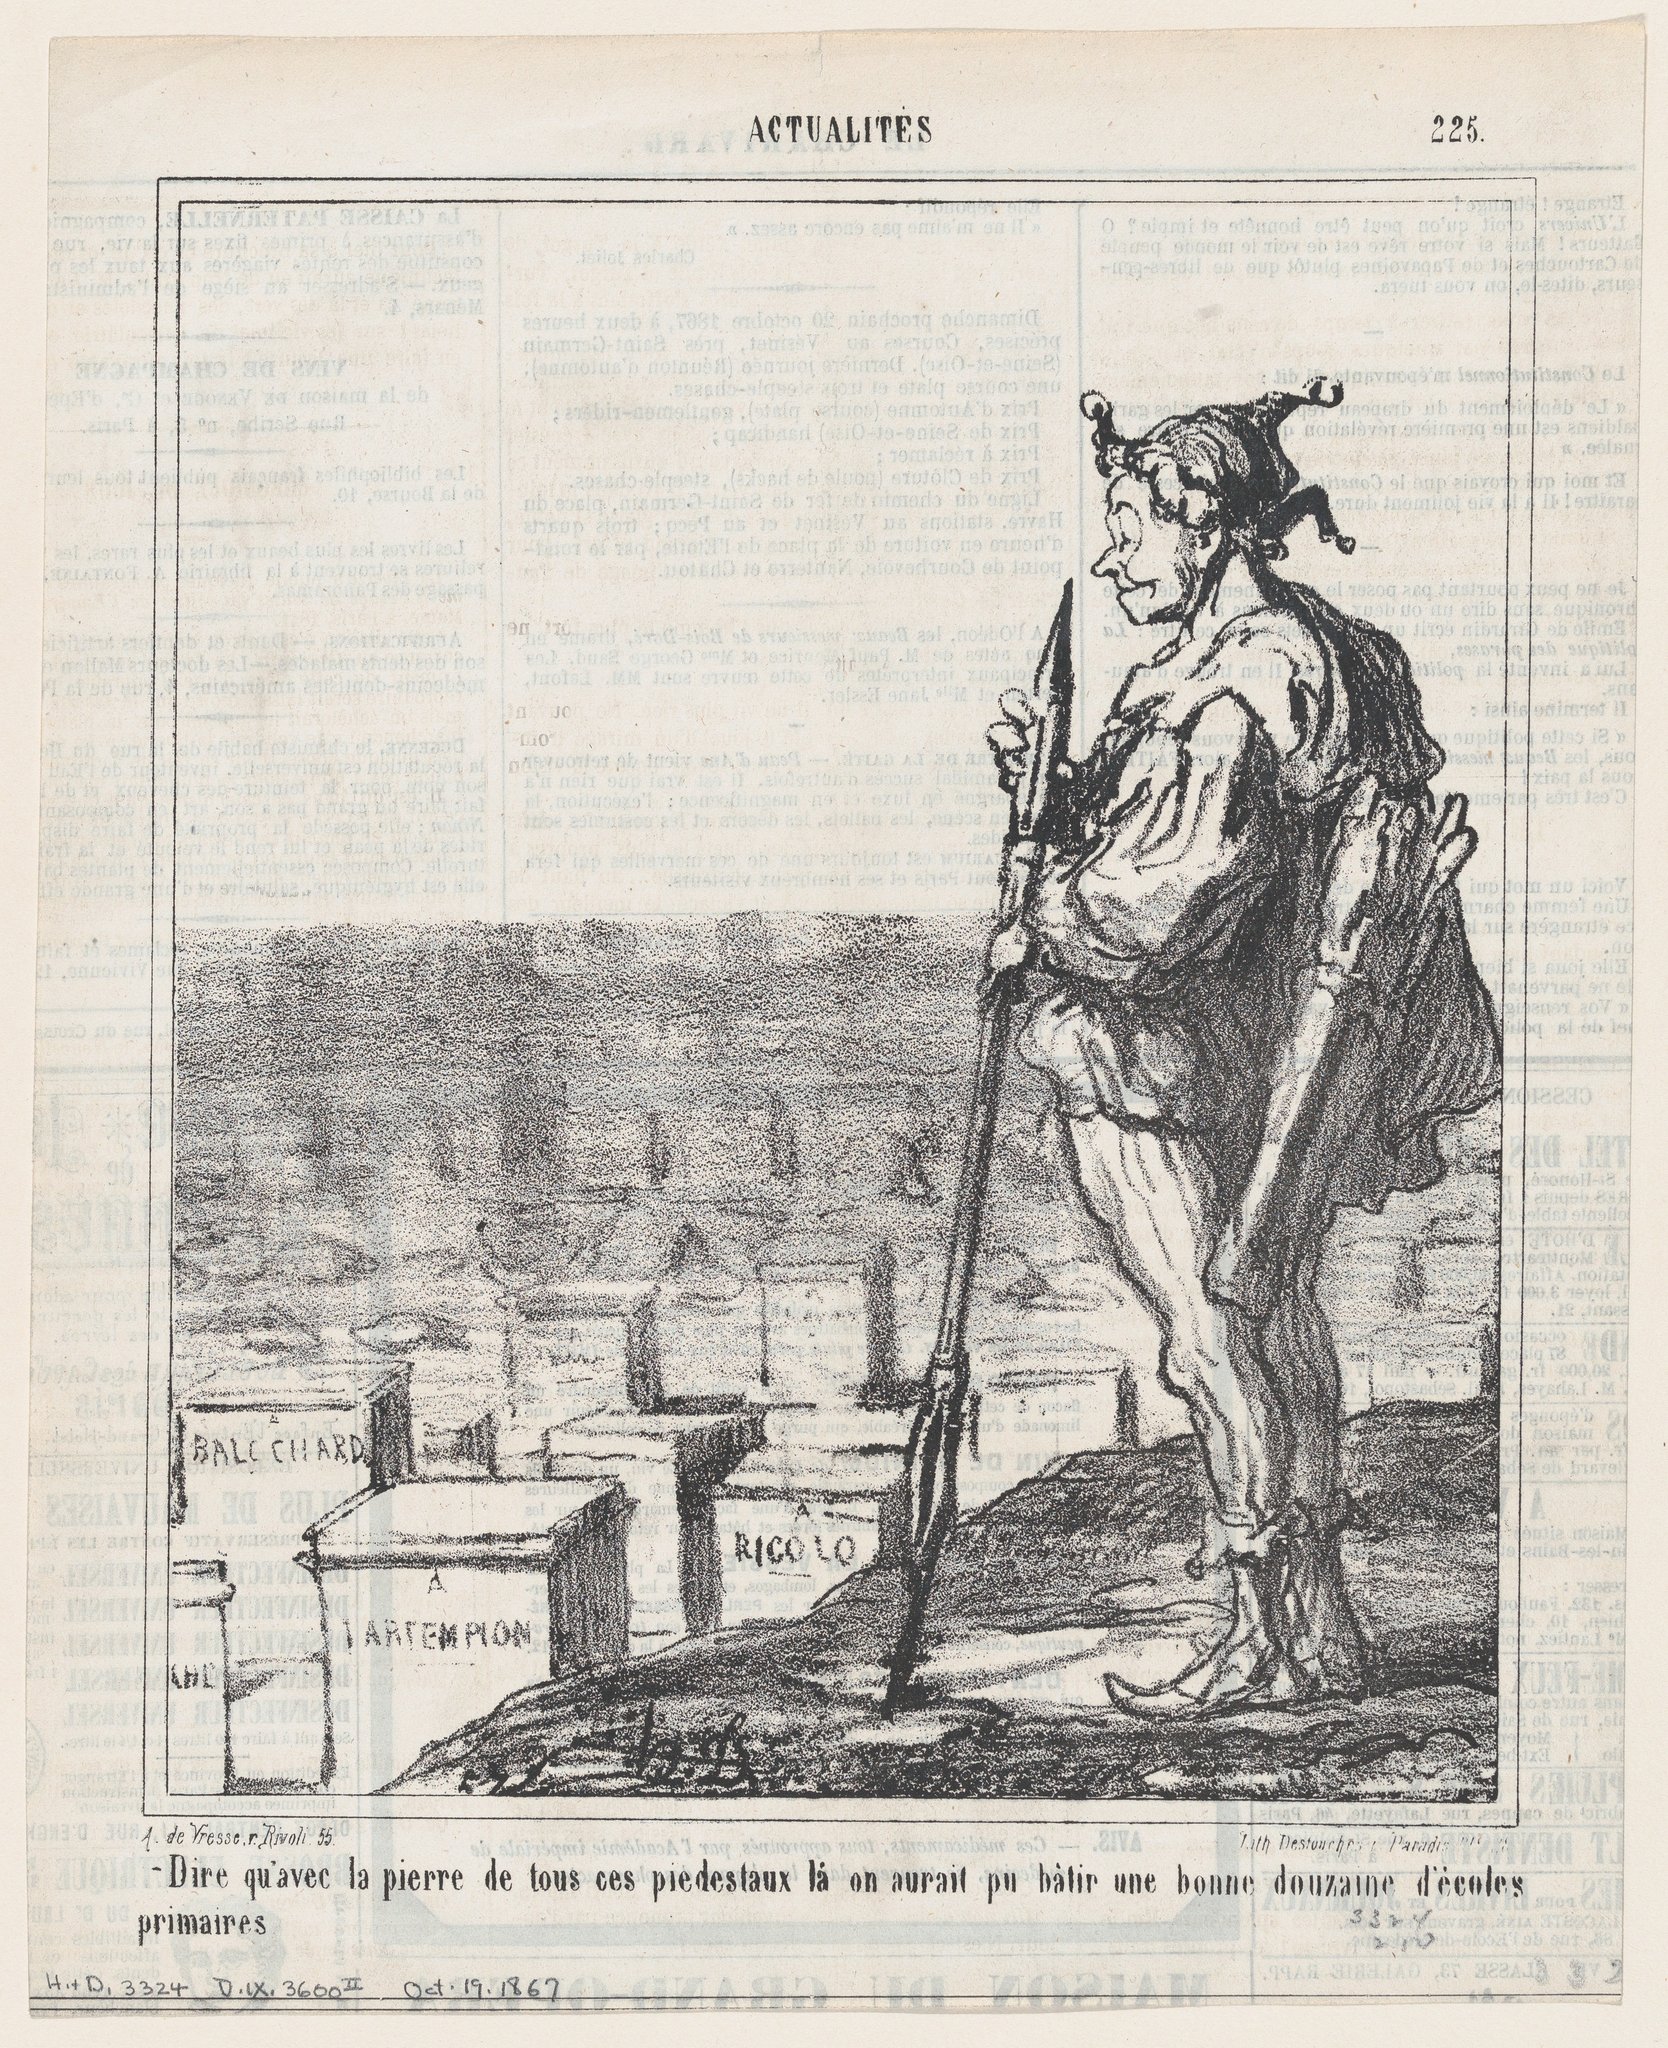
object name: print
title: To think that one would have been able to build a dozen primary schools with the stone of all these pedestals, from "News of the Day"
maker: honoré daumier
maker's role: artist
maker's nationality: french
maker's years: 1808-1879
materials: paper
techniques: lithograph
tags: satire,weapons,men